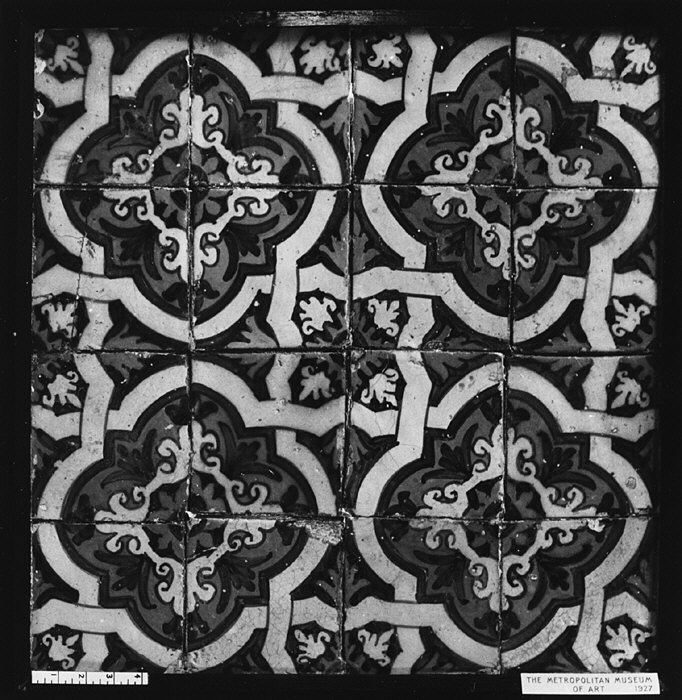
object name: tile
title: Tiles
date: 1651-1700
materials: earthenware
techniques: glazing